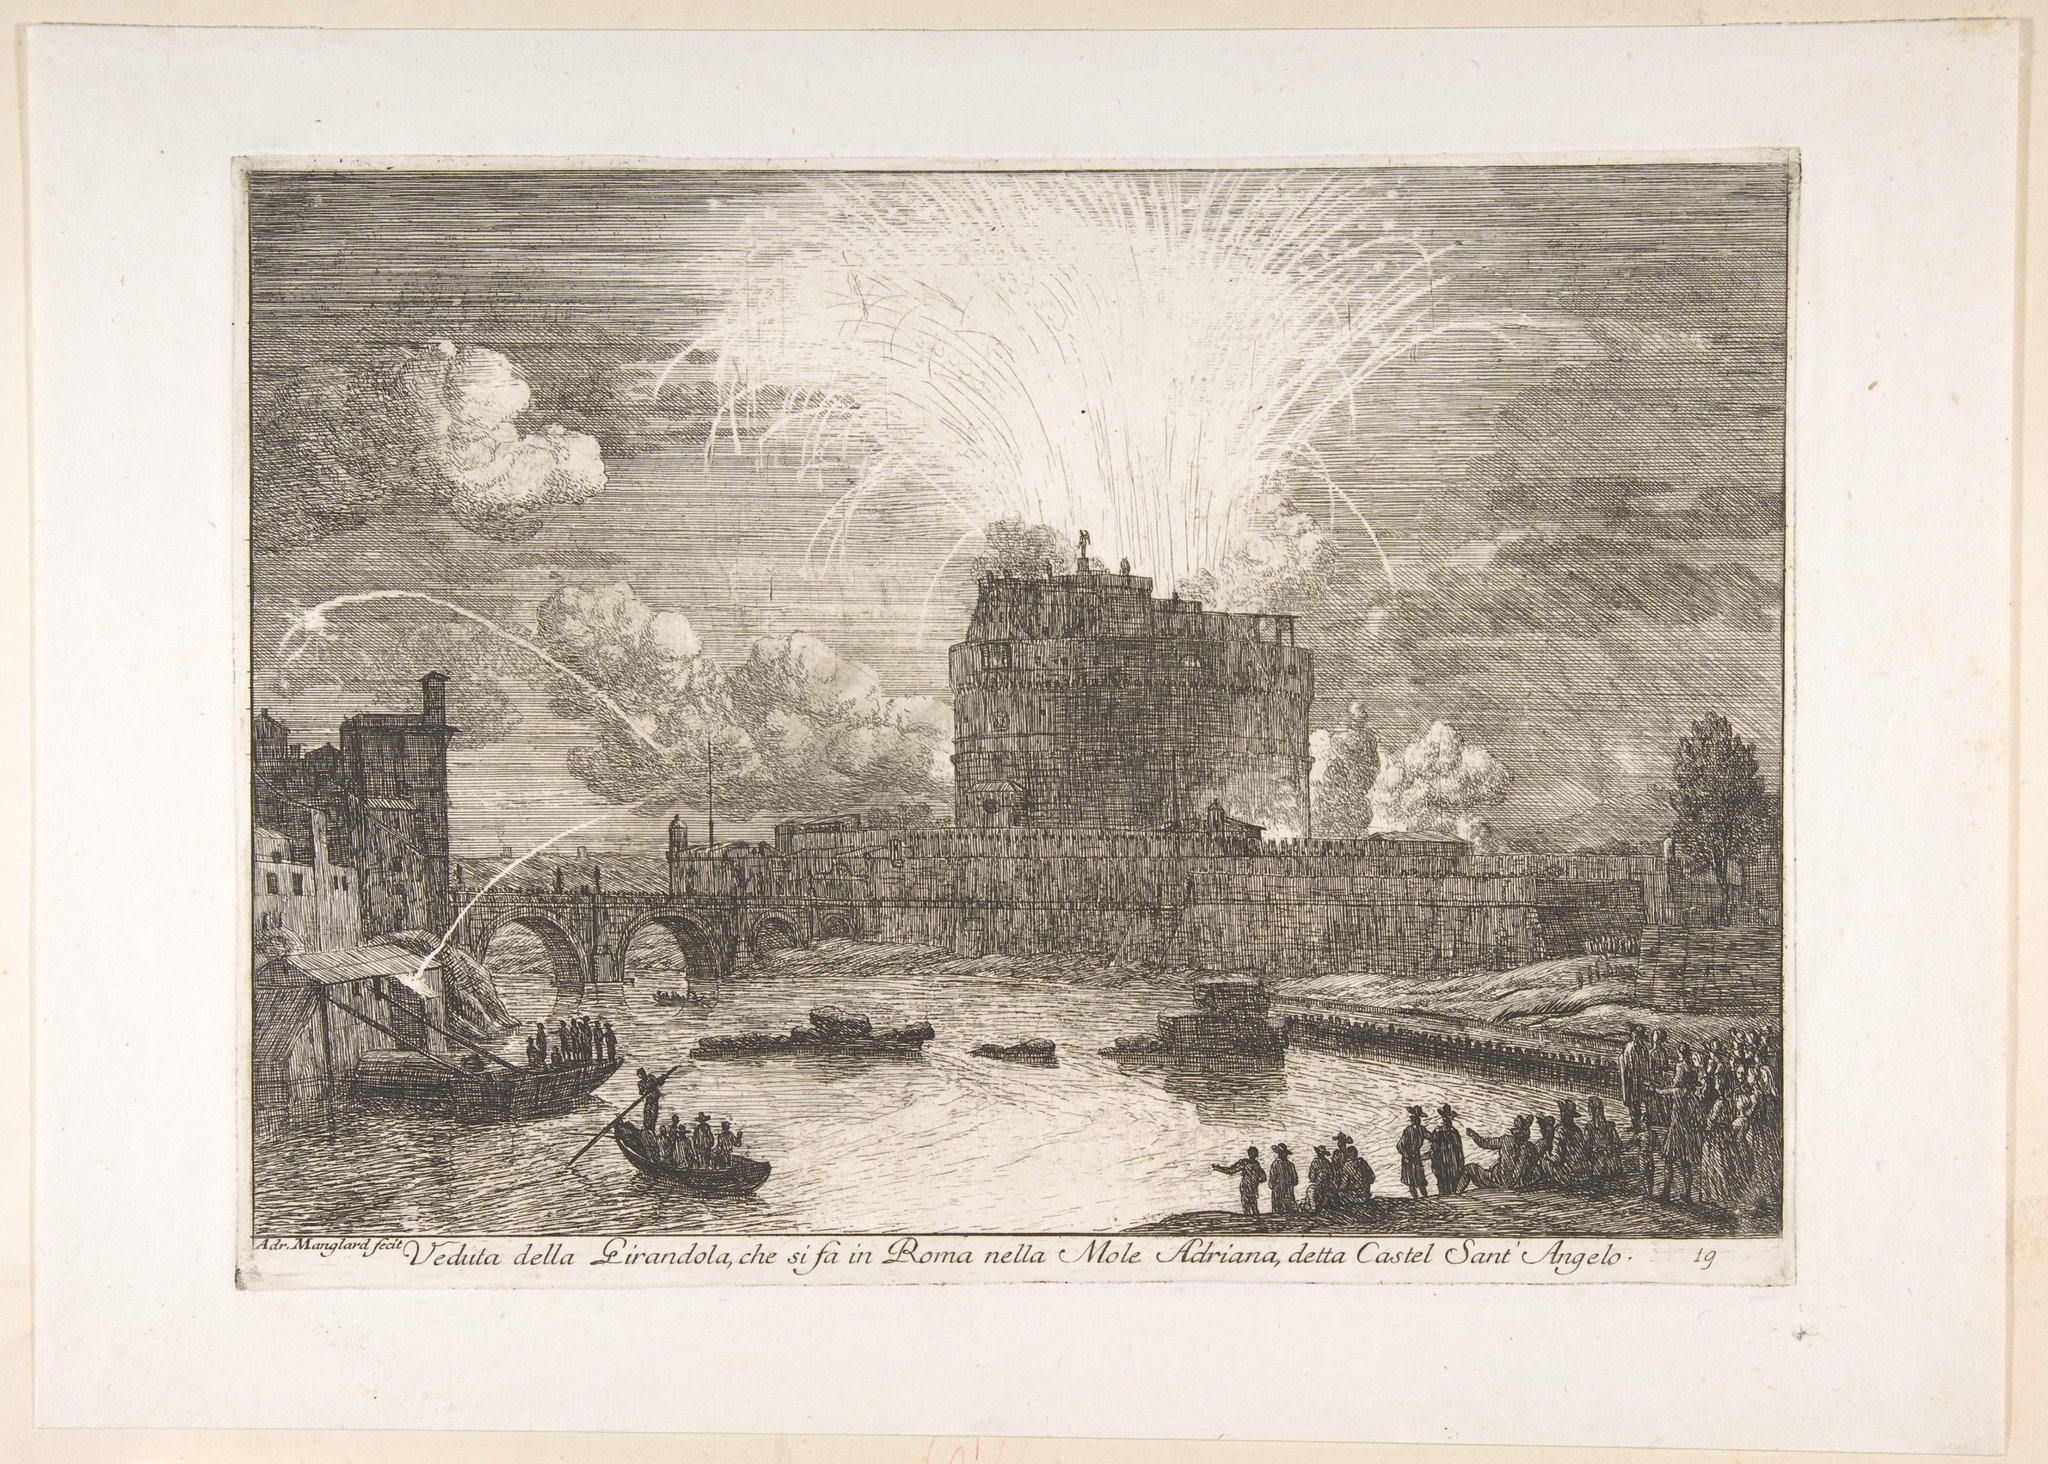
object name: print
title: Fireworks in Rome Over Castel Sant' Angelo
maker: adriaen manglard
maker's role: artist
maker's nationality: french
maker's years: 1695-1760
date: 1701-1800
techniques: etching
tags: castles,fireworks,boats,rome